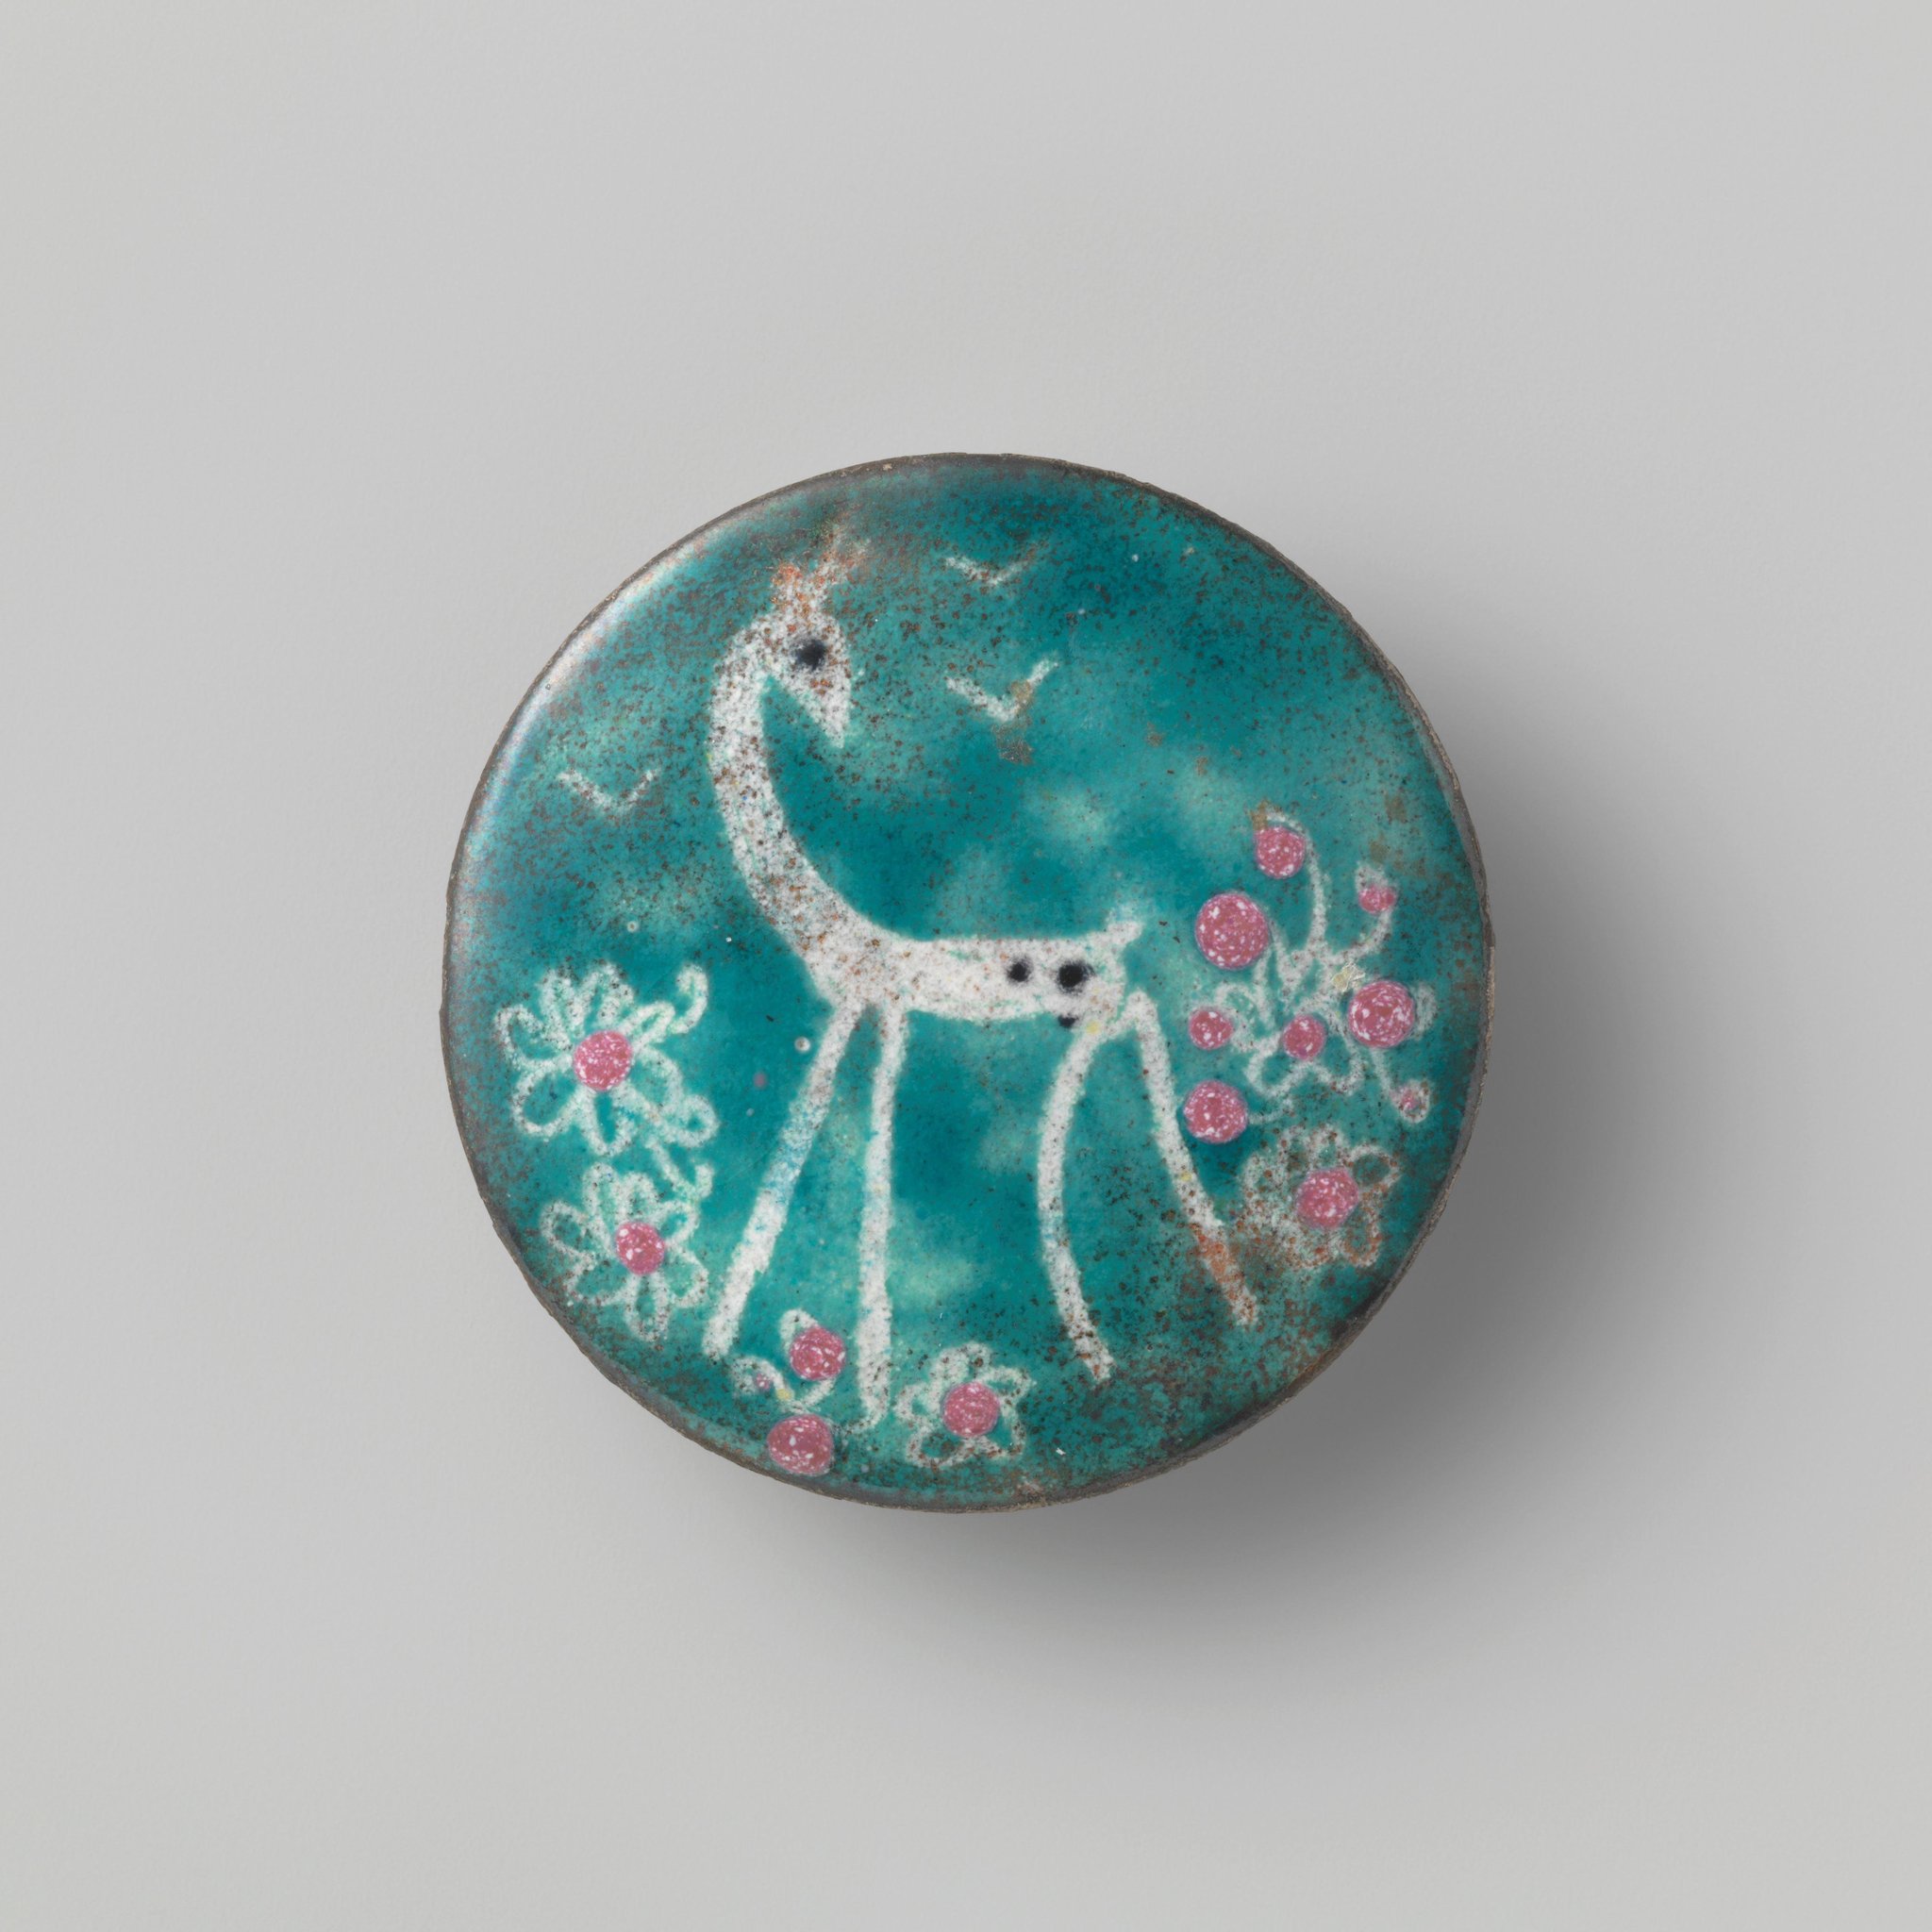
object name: brooch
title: Ronde broche van email op koper met giraffe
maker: Anonymous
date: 1950-1960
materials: copper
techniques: enameling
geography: netherlands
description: Ronde broche van email op koper voorzien van een haaksluiting. De giraffe is wit op een zeegroene achtergrond met enkele rose details.